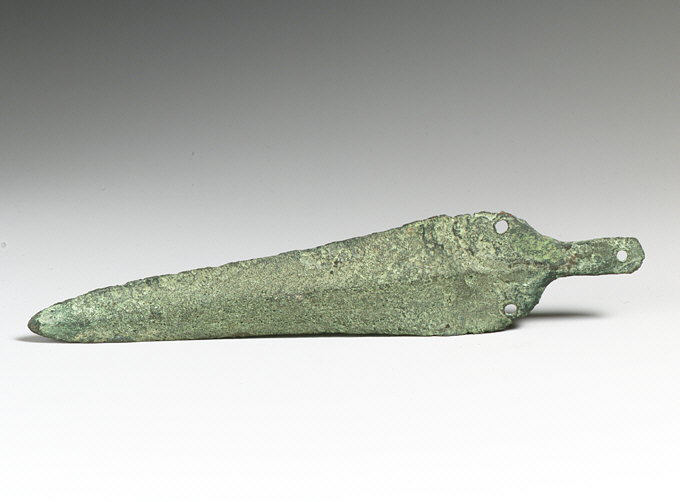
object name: dagger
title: Bronze dagger blade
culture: cypriot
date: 2000-1650 BCE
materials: bronze